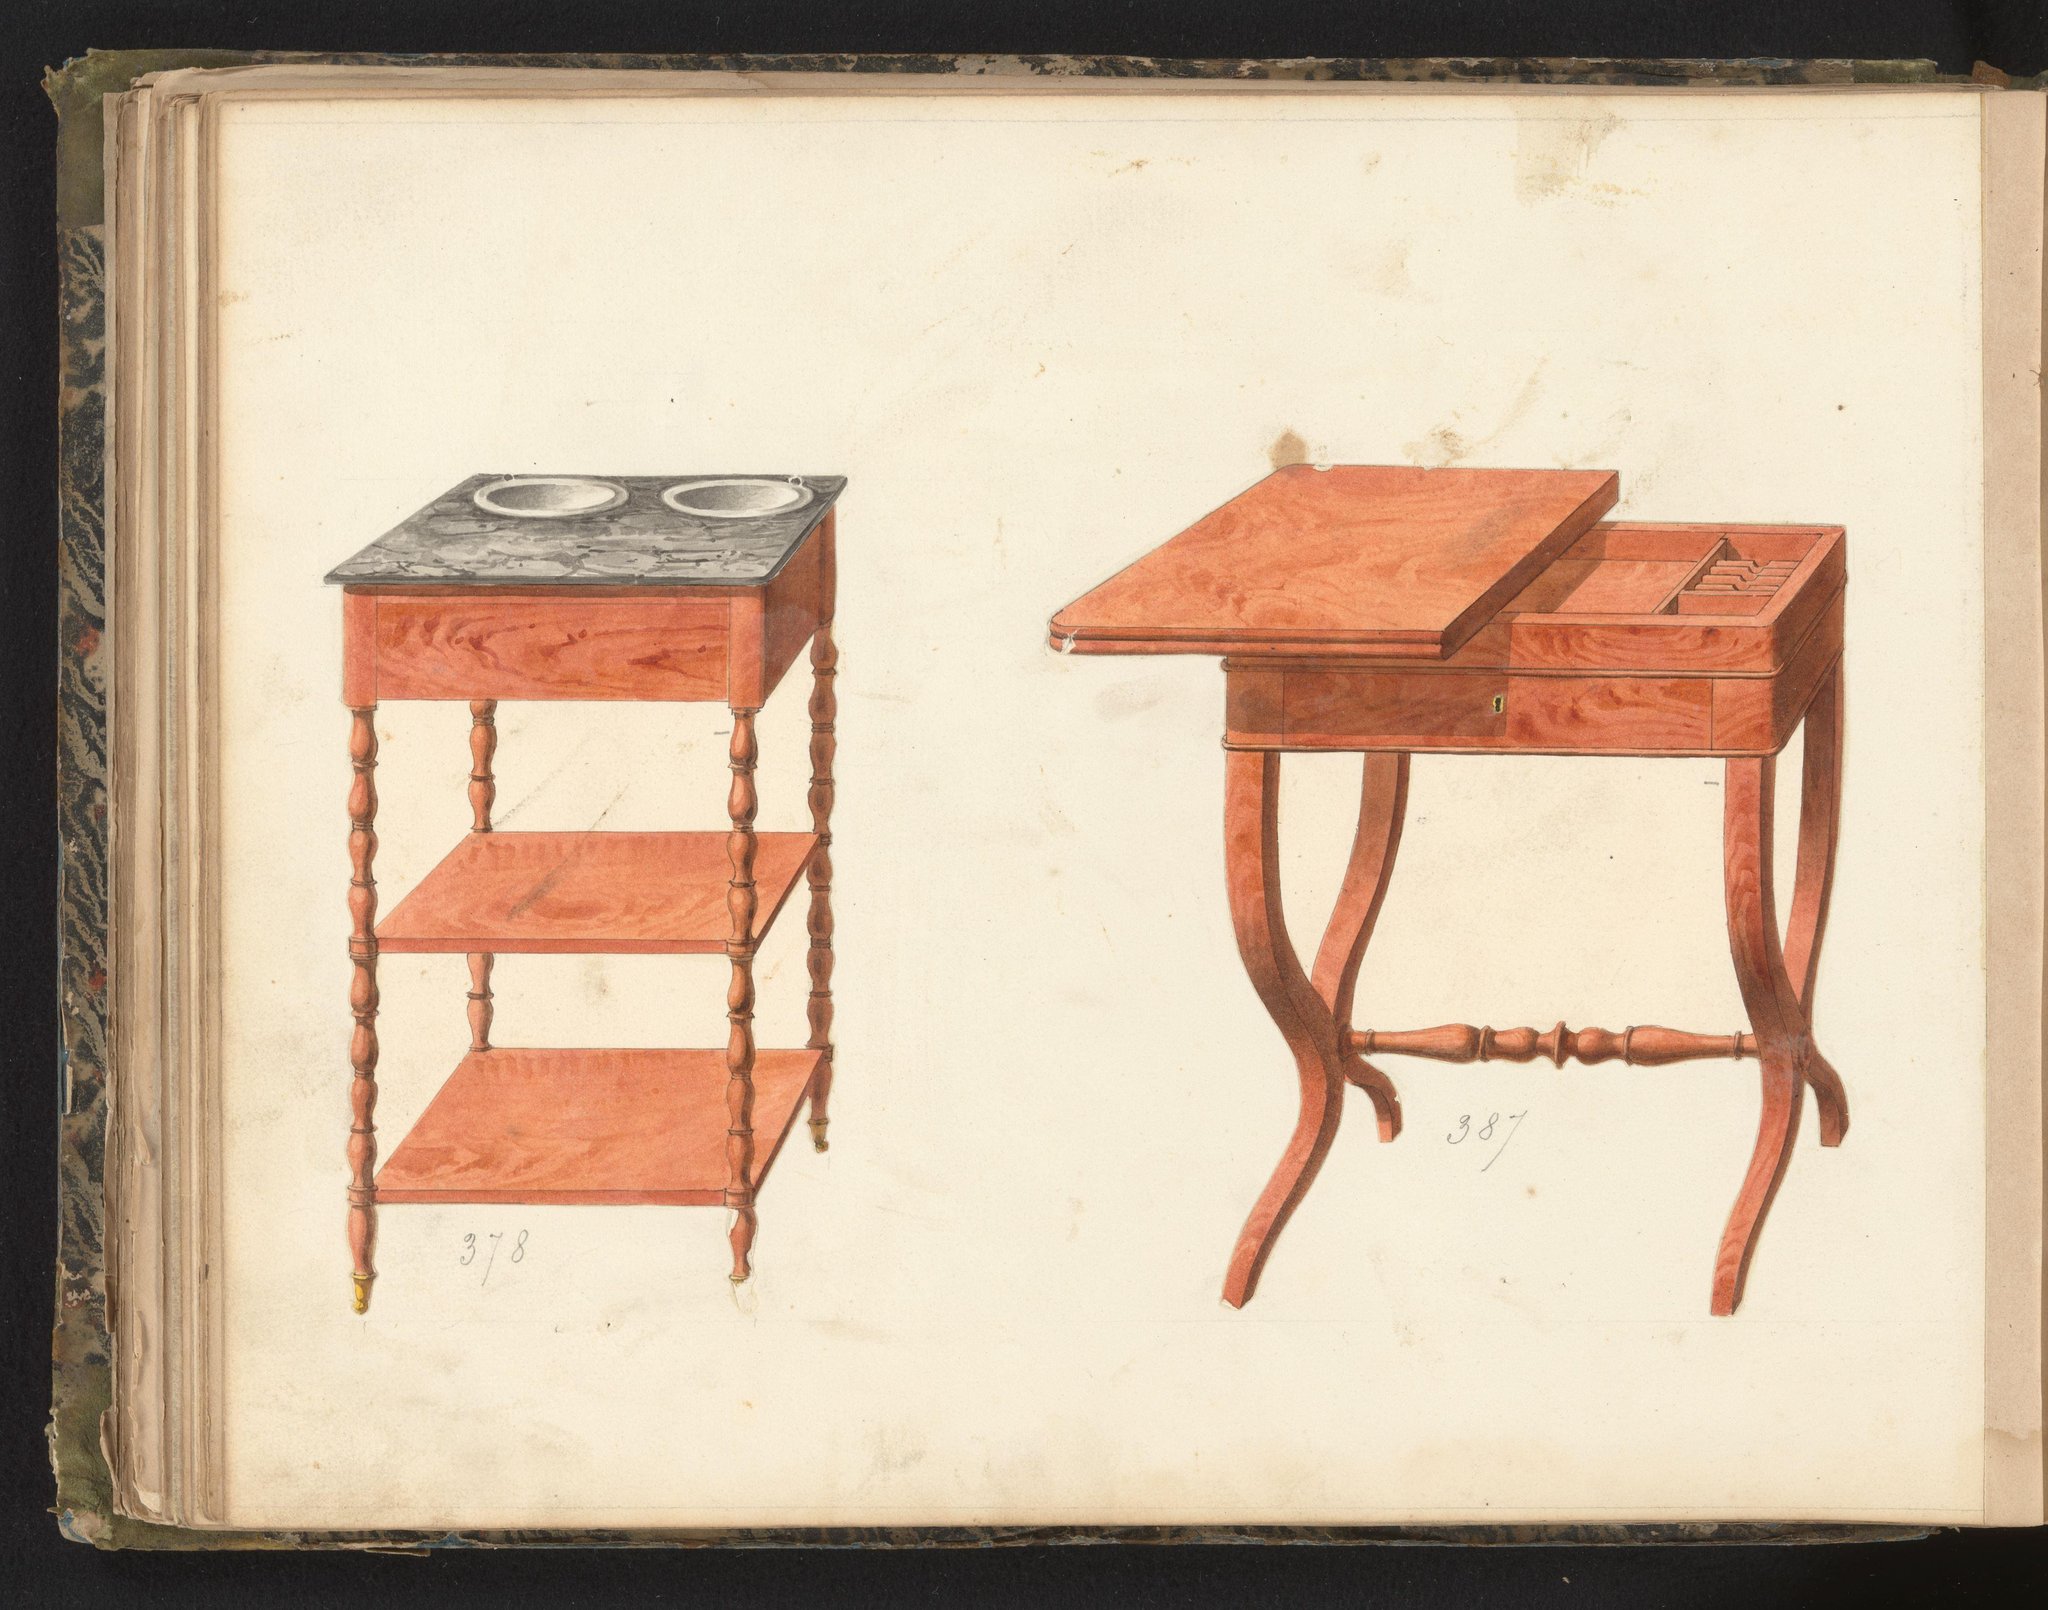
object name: drawing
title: Ontwerp voor een ‘bijzettafel’ en een speeltafel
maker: Anonymous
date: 1825-1839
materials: ink, paper, pencil, watercolor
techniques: brush, pen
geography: paris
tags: table (+ wood and other phytogenic material), table, board-games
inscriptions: inscription: ‘387 Table à piquet a X 20=14 378 Table Servante en acajou la même noyer vernis’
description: Een ‘bijzettafel’ met twee wasbakken in het marmeren tafelblad, op gedraaide poten en met twee planken en een speeltafel (table a piquet). Het blad op de achterzijde genummerd: 18, het tegenoverliggende blad met informatie over de afgebeelde meubelen genummerd: 18 bis. Onderdeel van een album met 80 bladen met tekeningen en een prent van gefineerde en gelakte meubelen, alsmede zitmeubelen.